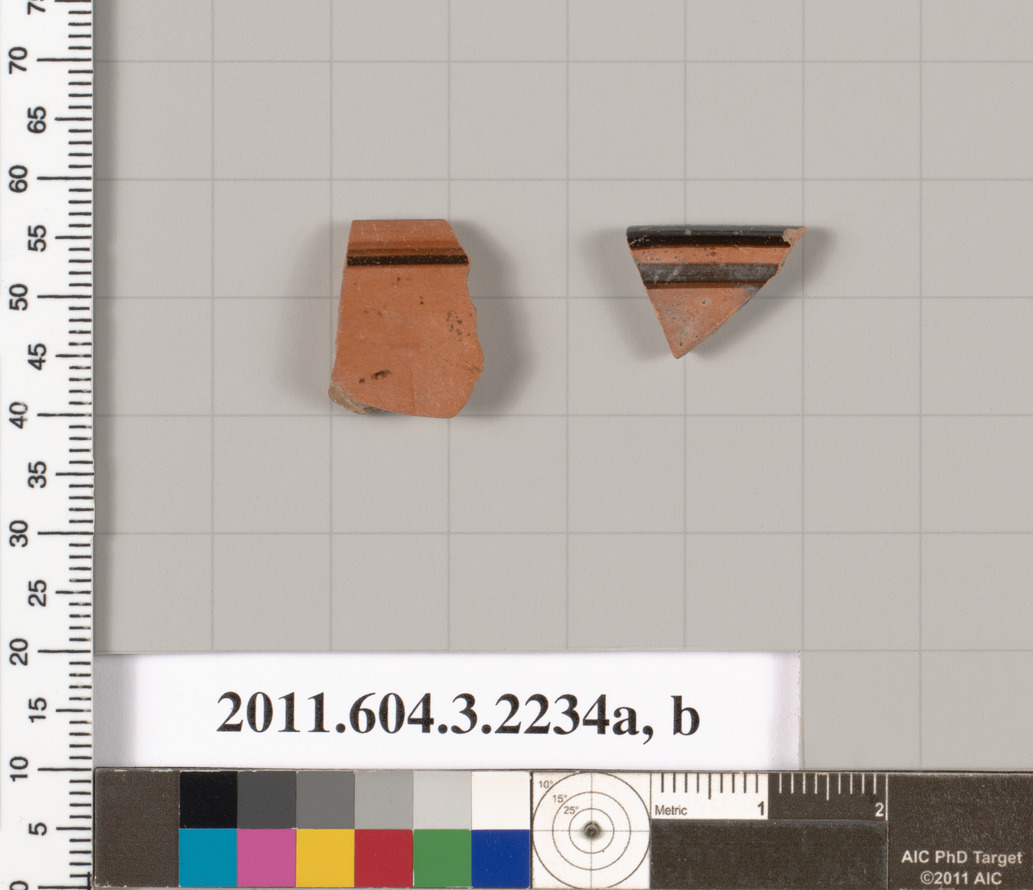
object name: kylix fragment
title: Terracotta rim fragments of kylikes (drinking cups)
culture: greek, attic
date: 600-401 BCE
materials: terracotta